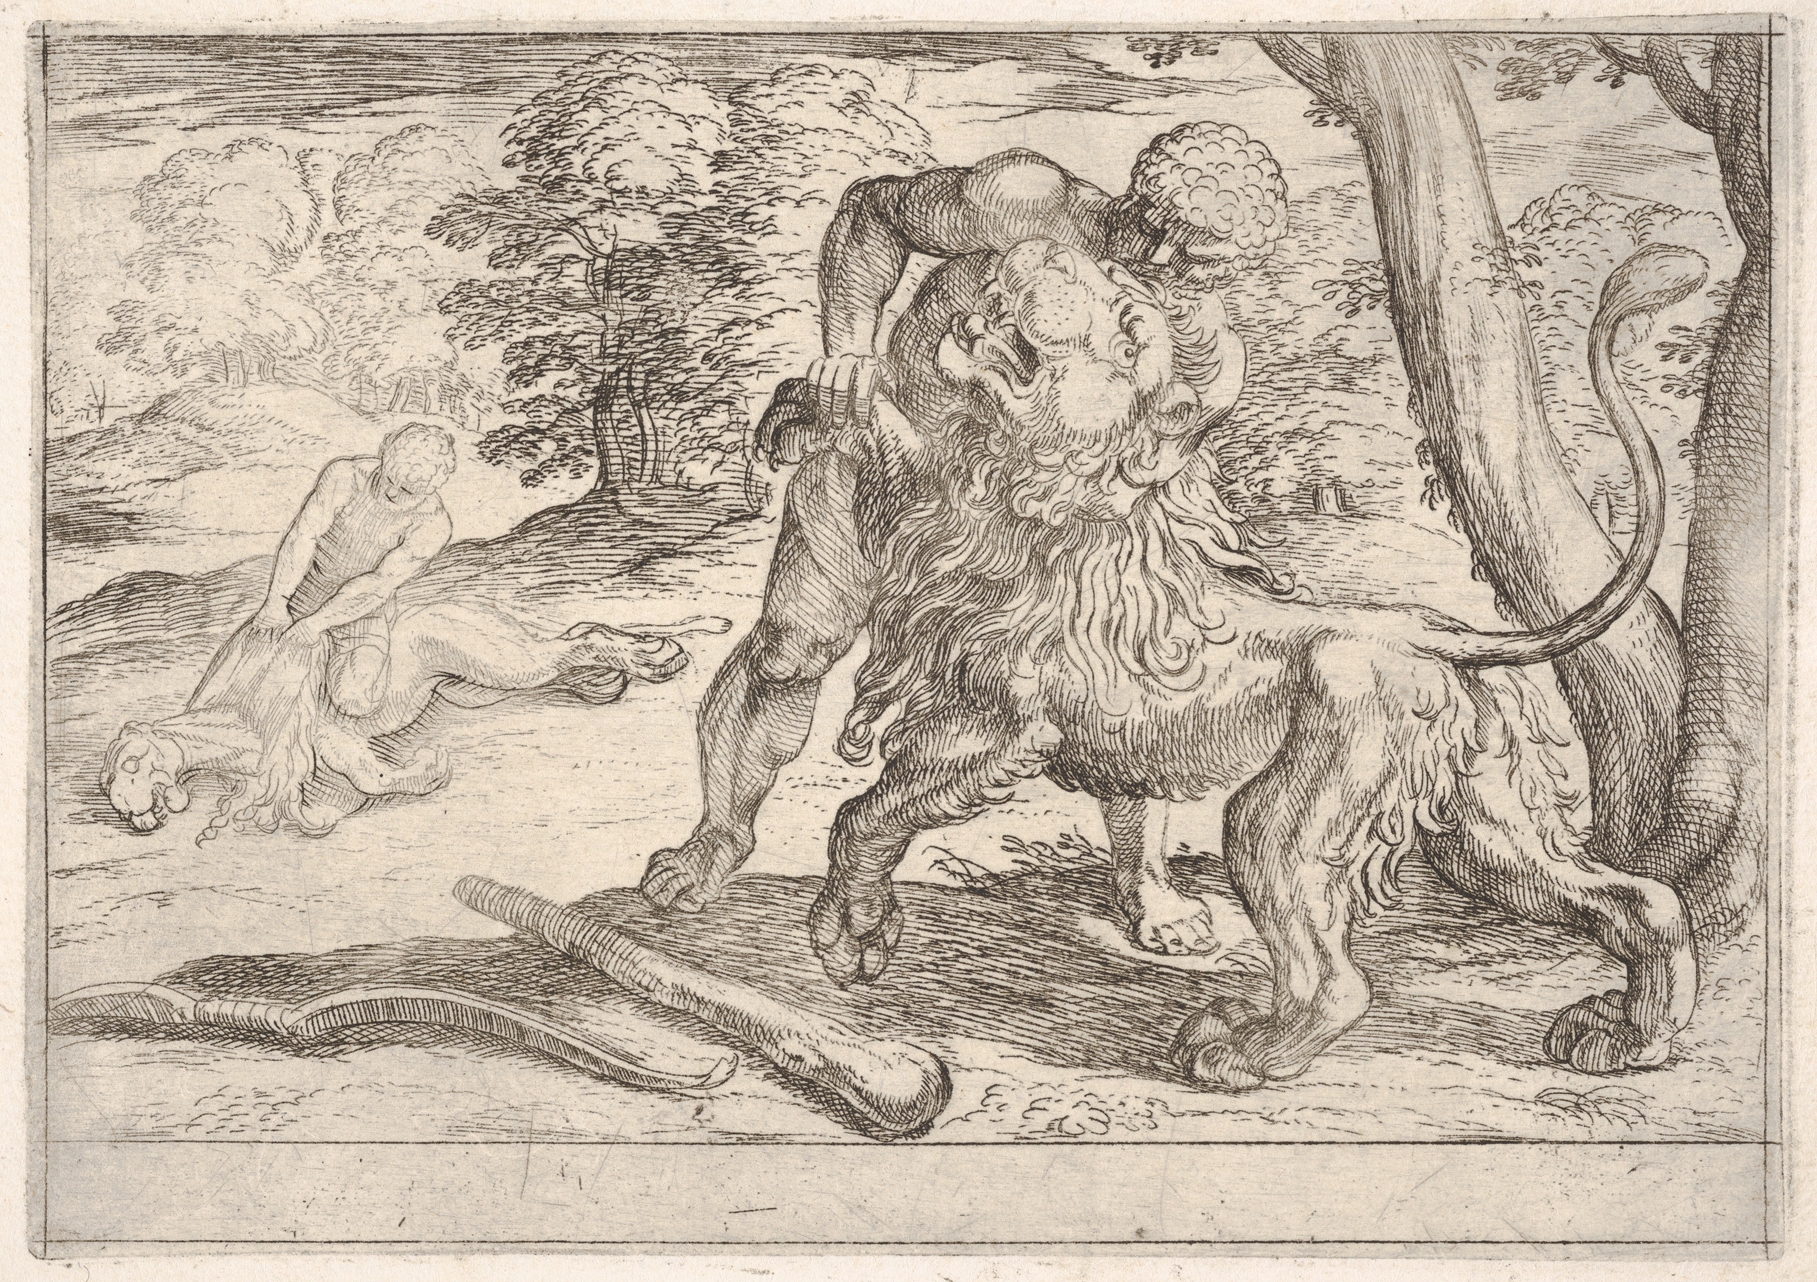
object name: print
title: Hercules and the Nemean Lion, from "The Labors of Hercules"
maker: antonio tempesta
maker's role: artist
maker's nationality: italian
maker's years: 1555-1630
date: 1608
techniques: etching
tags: hercules,lions